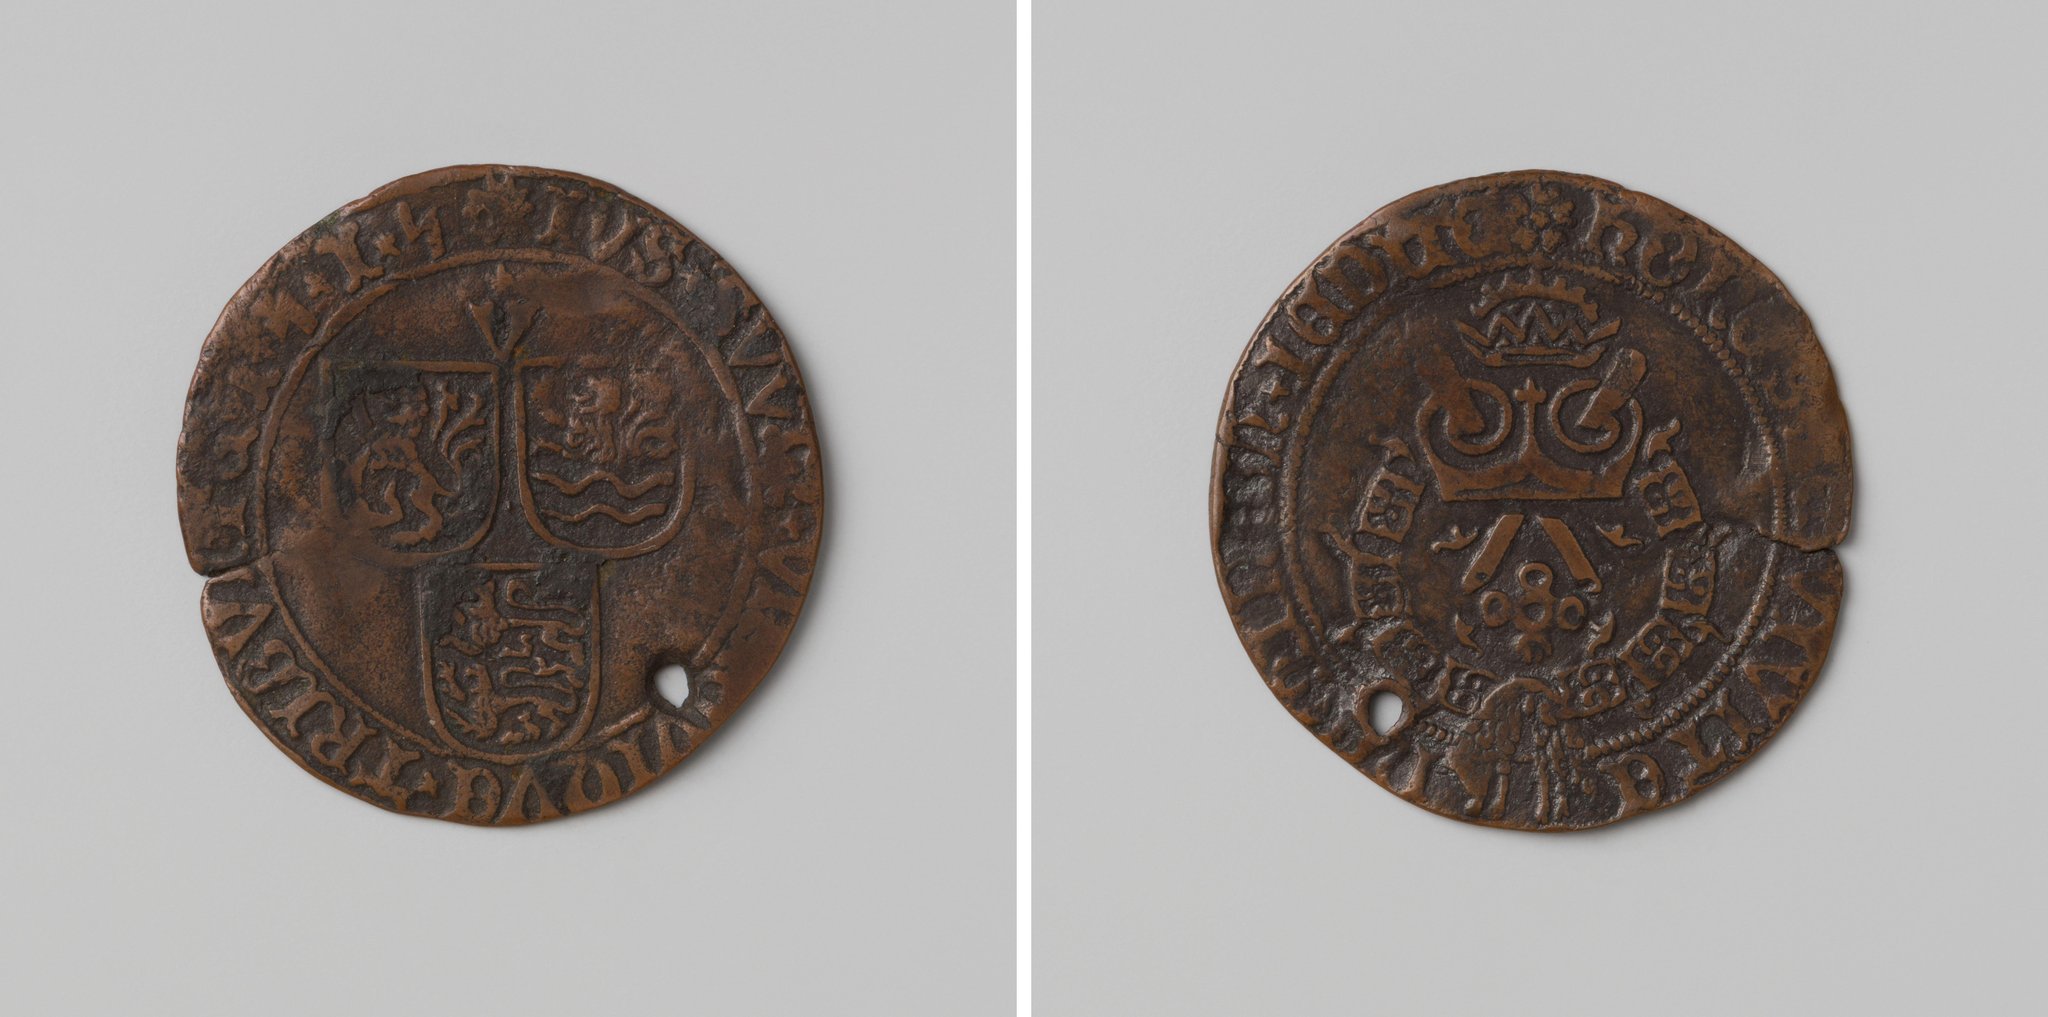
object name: jeton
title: Inhuldiging van Karel als graaf van Holland en Zeeland en heer van Friesland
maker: Anonymous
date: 1515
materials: copper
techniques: striking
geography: netherlands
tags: ghent, charles v (holy roman emperor and king of spain), zeeland, holland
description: Koperen penning met gat erin. Voorzijde: twee wapenschilden, geplaatst boven derde wapenschild onder letter V binnen omschrift. Keerzijde: gekroonde vuurslag op Bourgondisch kruis, omhangen met ordeteken van Gulden Vlies binnen omschrift